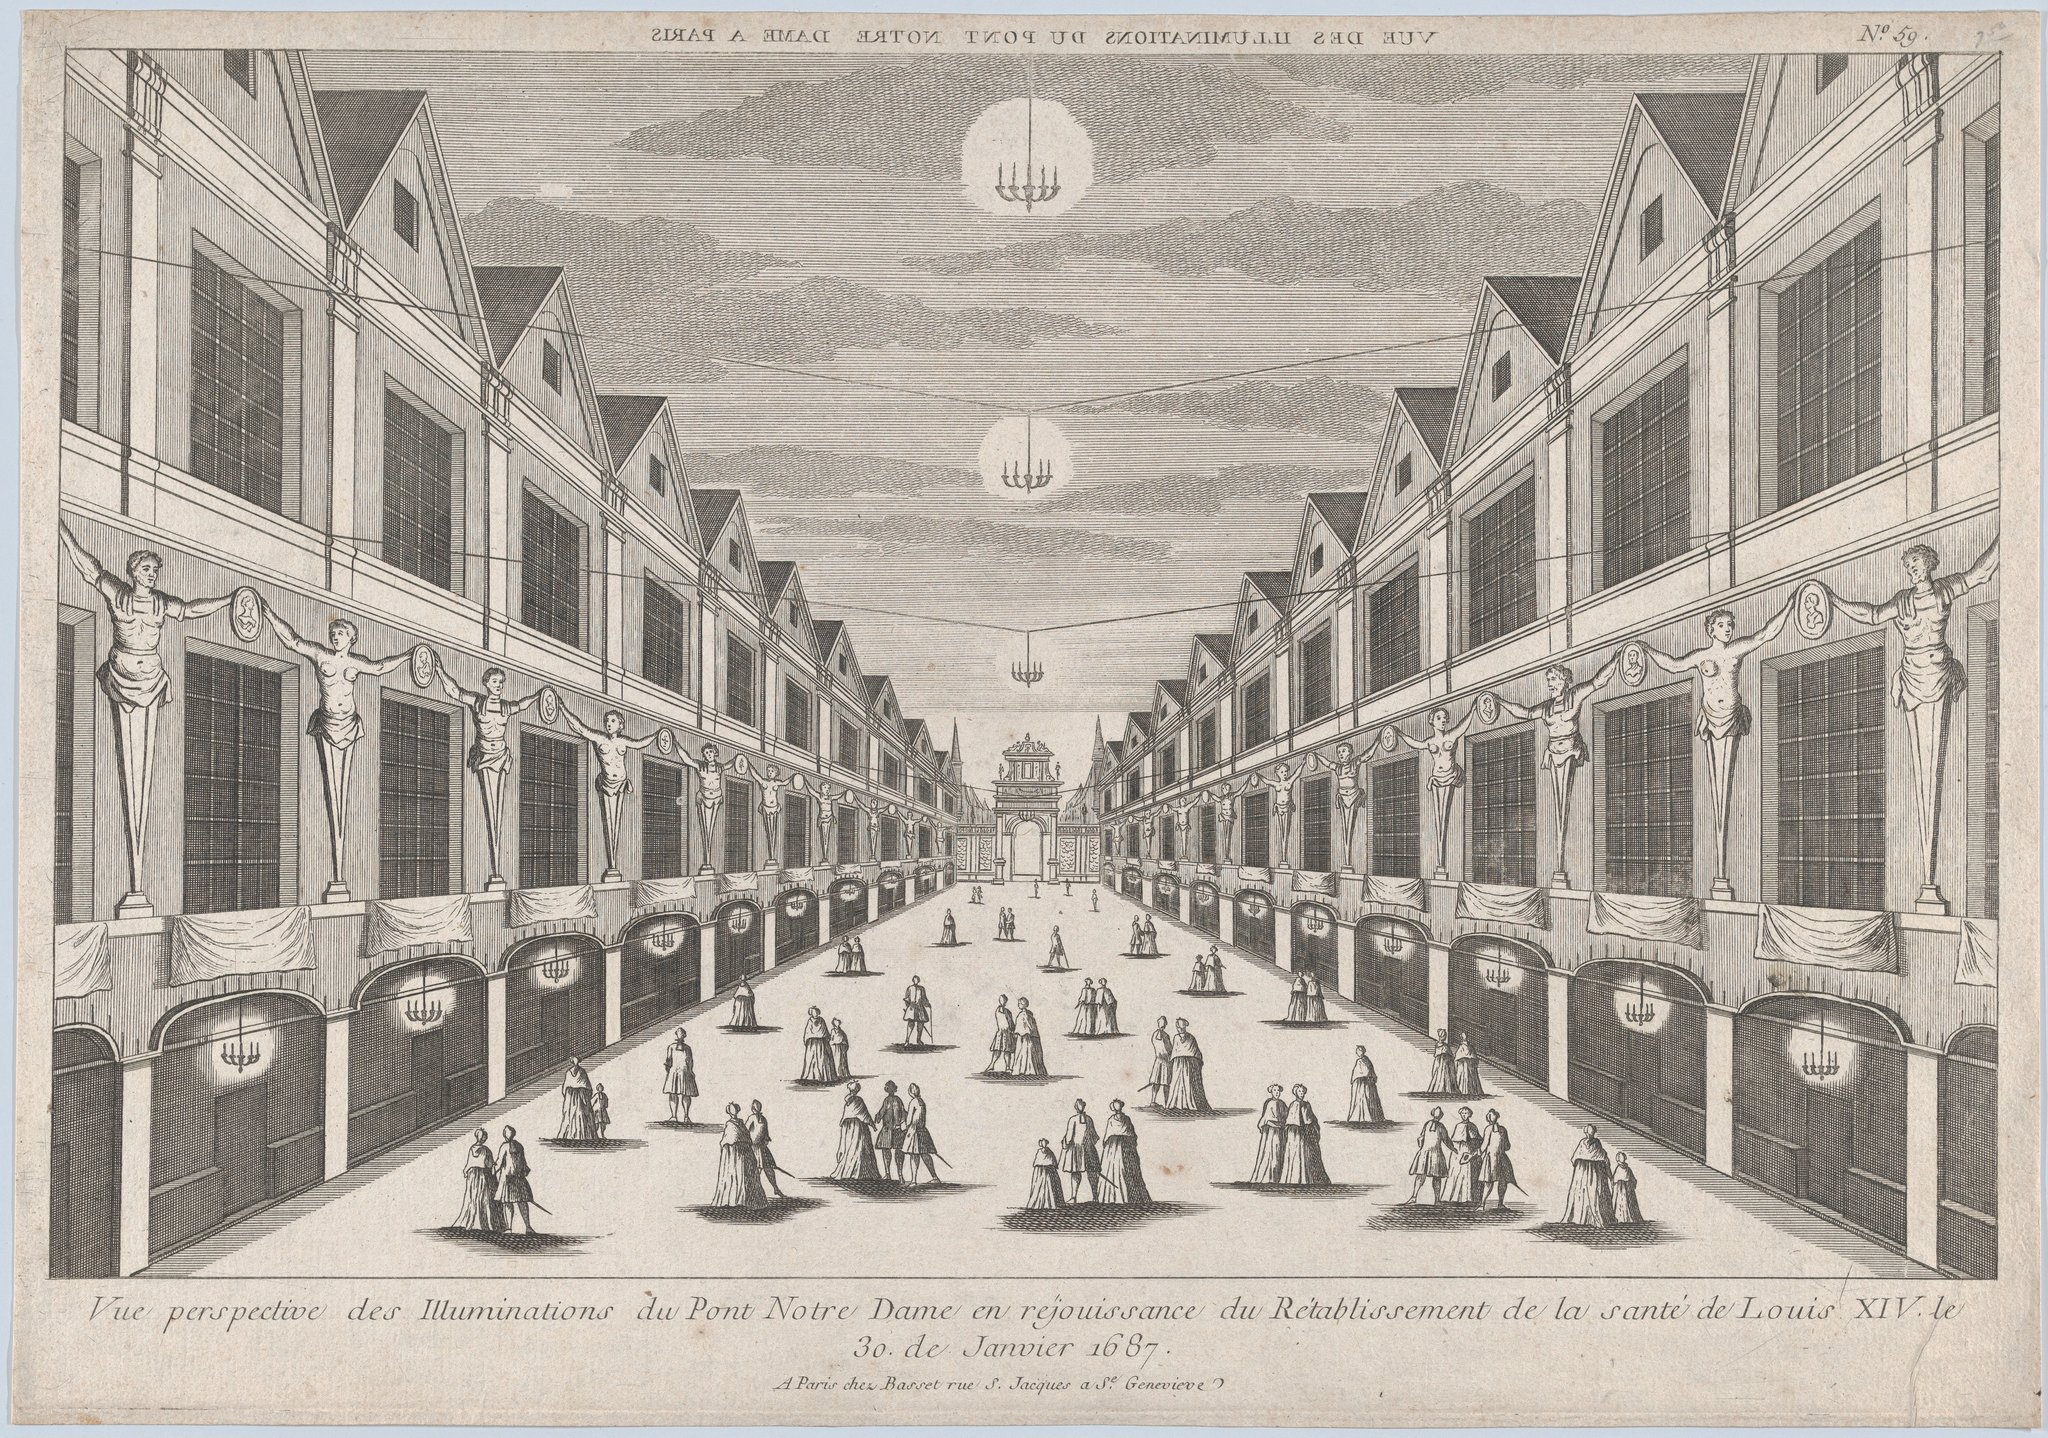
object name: print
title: Perspective view of the Illuminations on the Pont Notre Dame, in celebration of the recovery of the health of Louis XIV, January 30, 1687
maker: Anonymous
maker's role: artist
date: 1750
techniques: engraving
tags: human figures,buildings